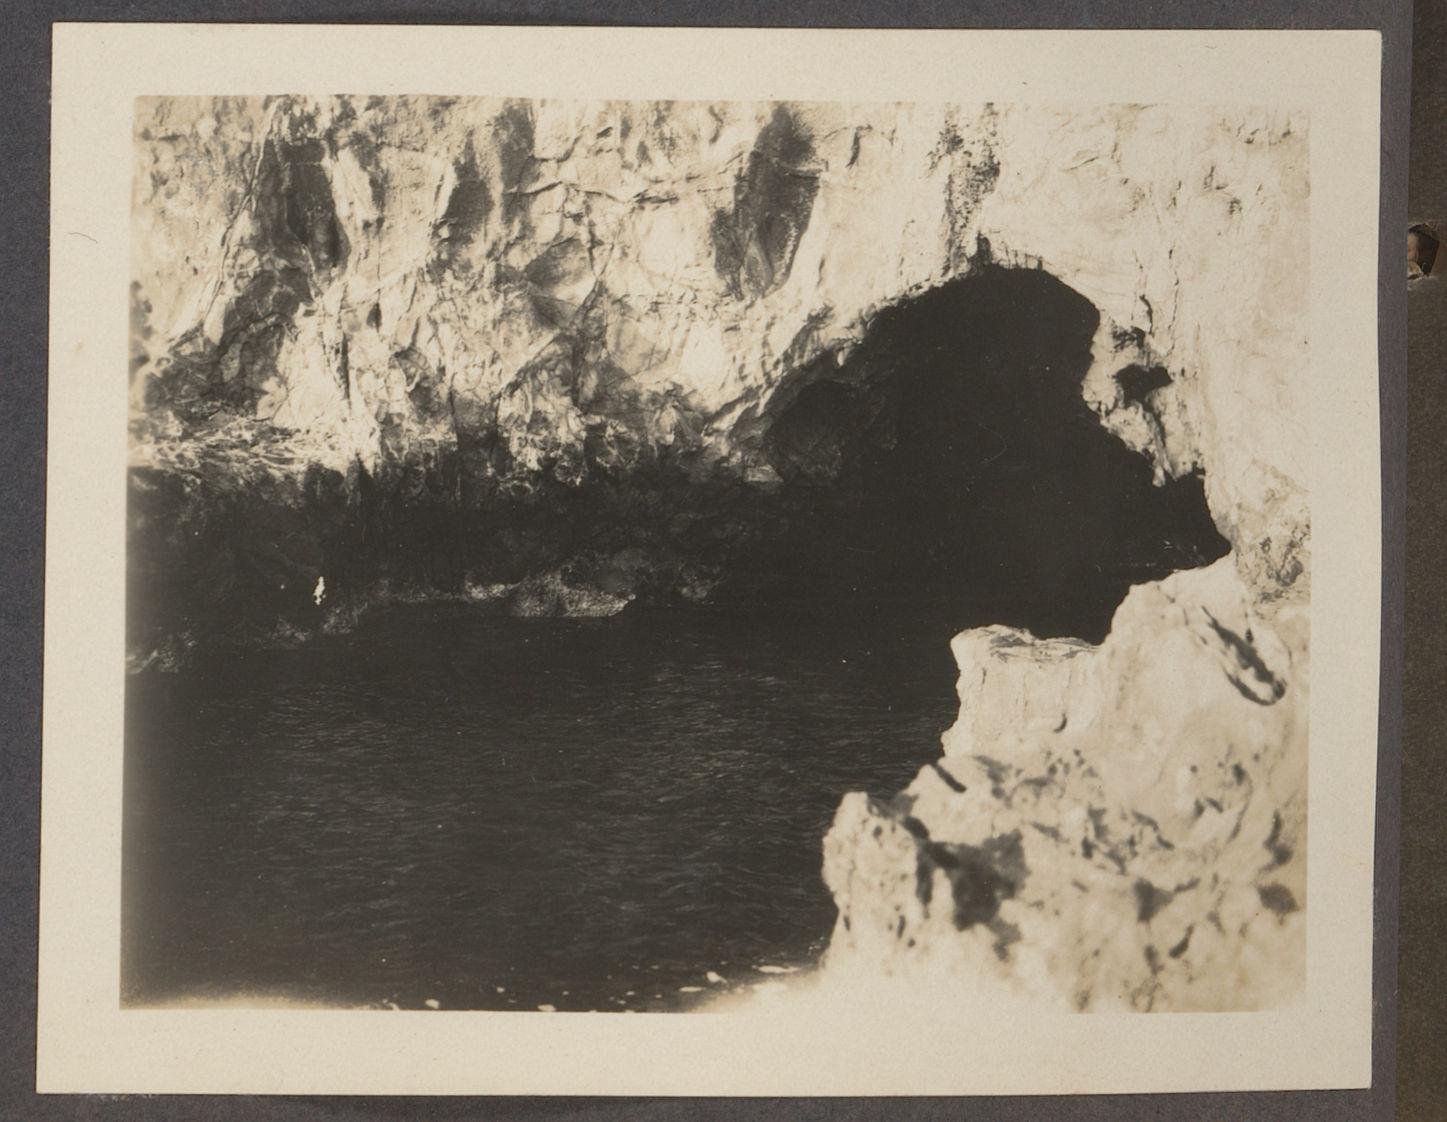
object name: photograph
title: Grot bij de kust te Los Angeles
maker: Anonymous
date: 1928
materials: photographic support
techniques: gelatin silver print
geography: pacoima canyon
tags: cave, grotto, coast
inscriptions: annotation: ‘Grot in kust nabij San Pedro’